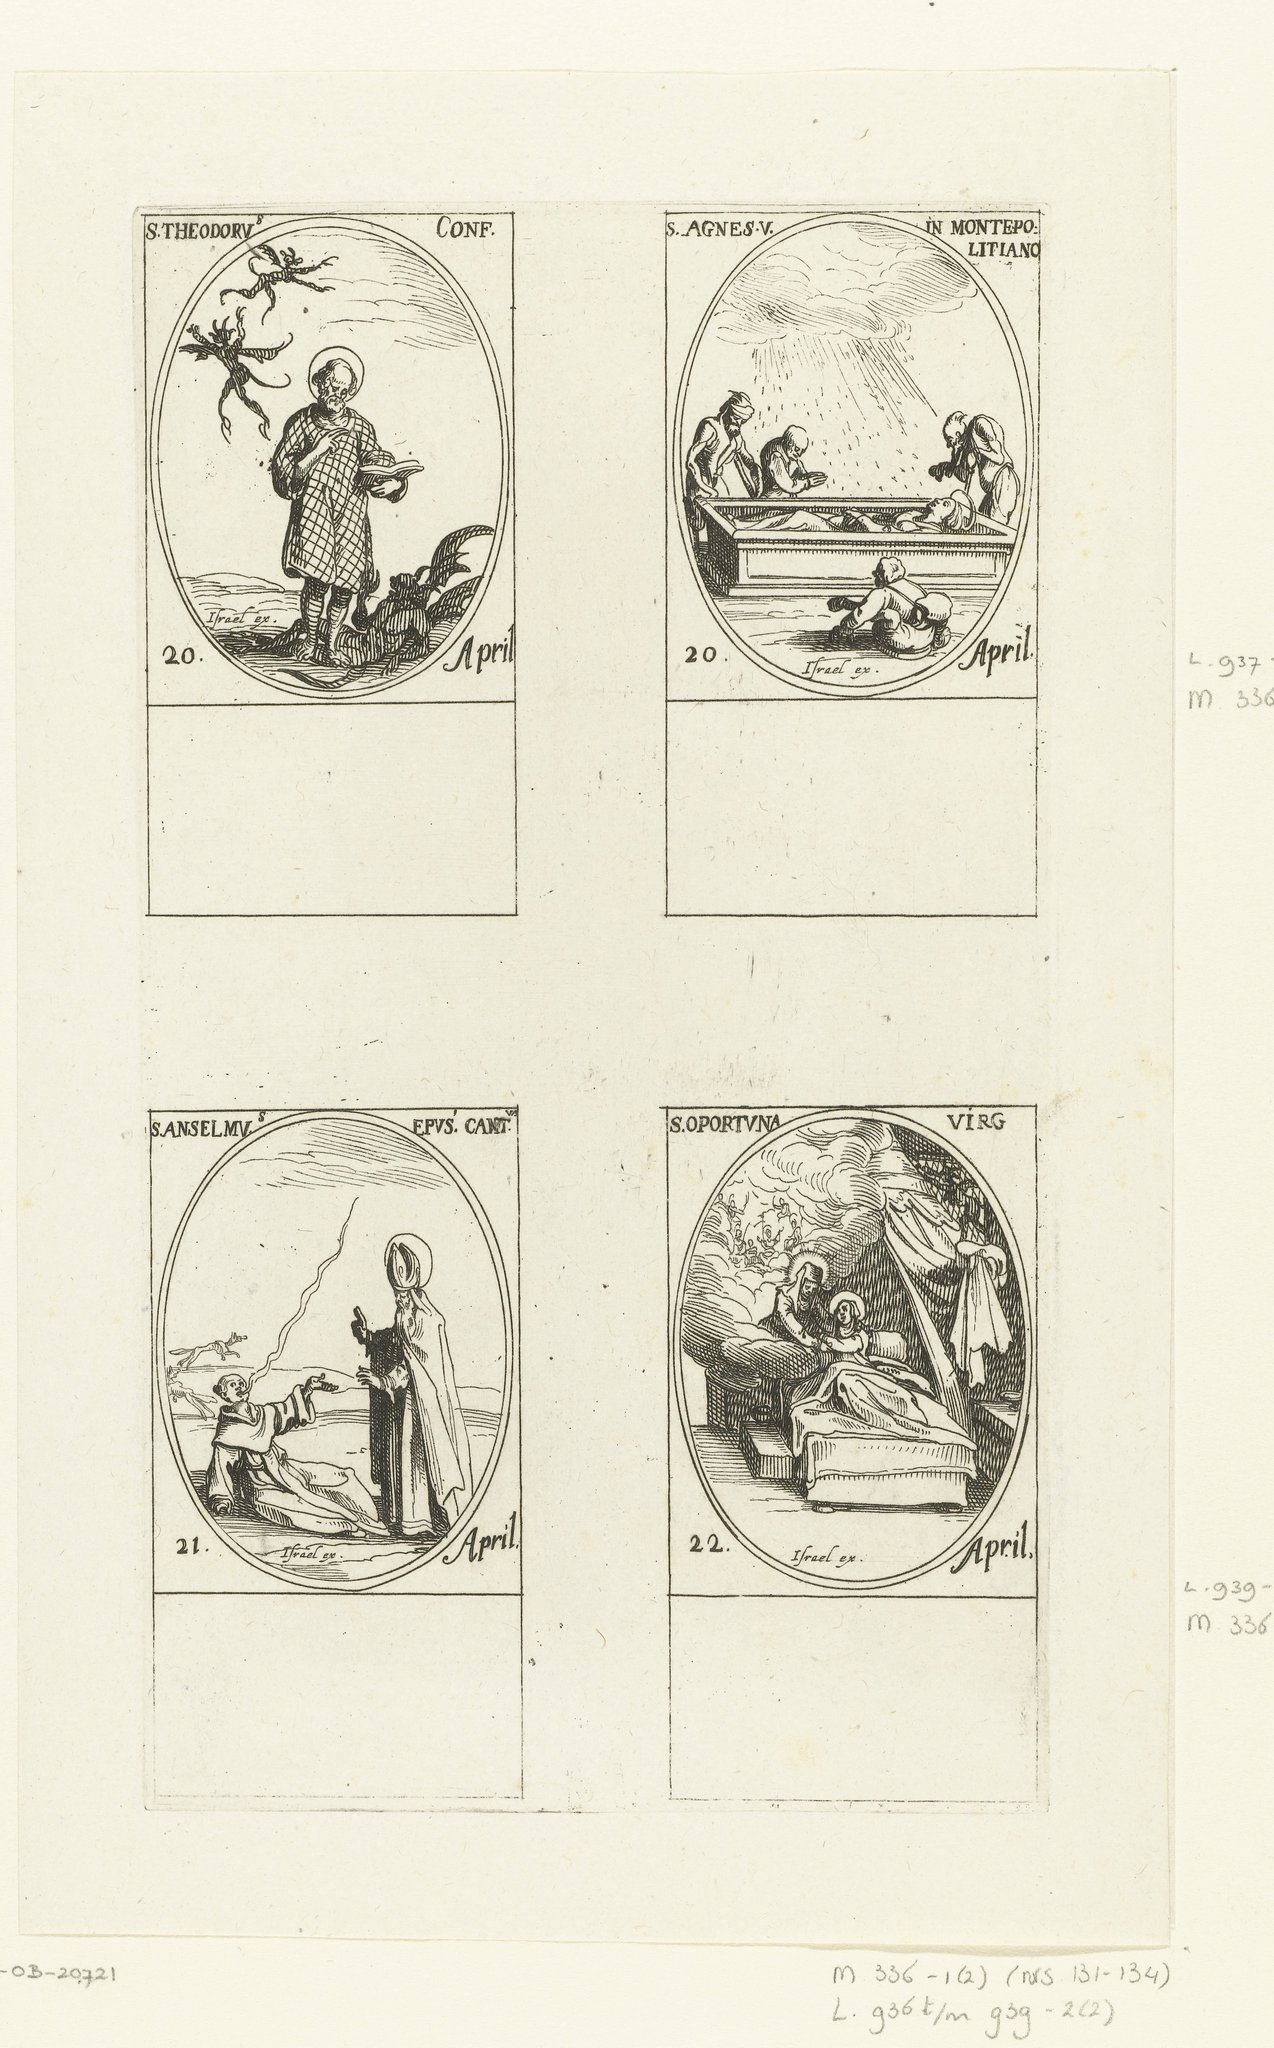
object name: print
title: Alle heiligen en de Christelijke feestdagen van het jaar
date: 1632-1636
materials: paper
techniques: etching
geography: paris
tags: female saints (with name), the benedictine monk anselm, archbishop of canterbury; possible attributes: book, pen, ship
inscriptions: collector's mark: Lugt 240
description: Blad met vier ovale voorstellingen, elk met opschrift en datum in het Latijn: linksboven de Heilige Theodorus Trichinas die een duivels wezen vertrapt, rechtsboven de Heilige Agnes van Montepulciano in haar graf, linksonder de Heilige Anselmus van Canterbury die een monnik aanspreekt bij wie rook uit de mond komt, rechtsonder de Heilige Opportuna omarmd, liggend in bed, Maria. Deze prent is onderdeel van een serie prenten met voorstellingen van de heiligen en de christelijke feestdagen van het jaar. Er zijn steeds vier scènes van één plaat op één blad gedrukt. Inclusief bijbehorend titelblad en frontispice gaat het in totaal om 124 platen (490 voorstellingen). De drie platen met de laatste 12 scènes (de veranderlijke christelijke feestdagen) zijn in de derde staat versneden tot 12 kleine plaatjes, en met een apart titelblad uitgegeven.